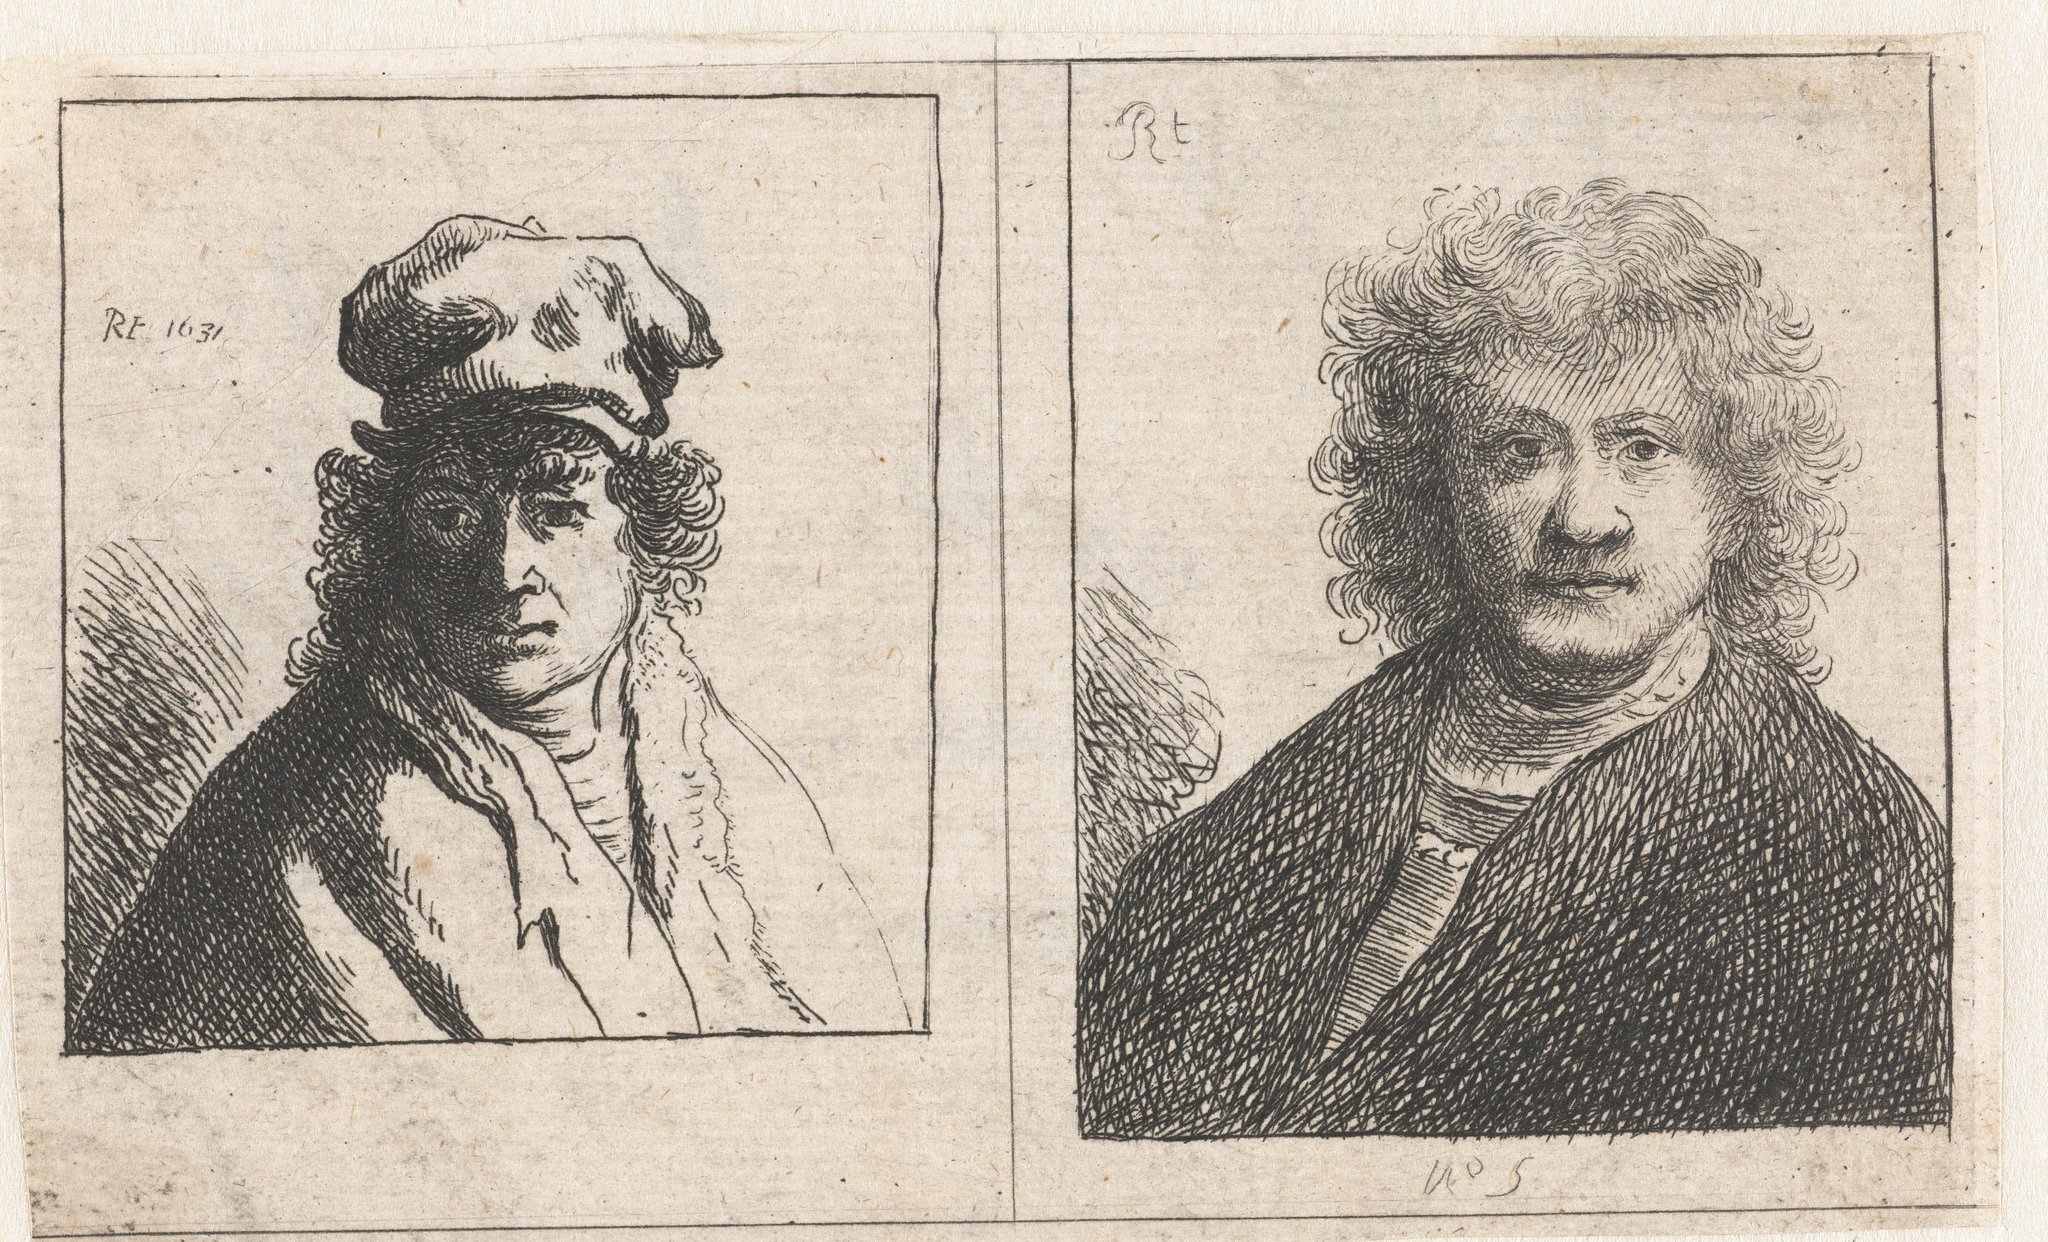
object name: print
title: Self-portrait with a broad nose and young man in cap: bust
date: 1807-1808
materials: paper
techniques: engraving, etching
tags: leiden, amsterdam, painter, print maker, draughtsman, rembrandt van rijn, adult man, portrait, self-portrait of graphic artist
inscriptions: collector's mark: Lugt 2228, collector's mark: Lugt 2760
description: Prent gebruikt in: Basan, H.L. Recueil de quatre-vingt-cinq estampes originales, tetes, paysages et différens sujets, dessinées et gravées par Rembrandt. Parijs: Henry Louis Basan, 1807-1808.